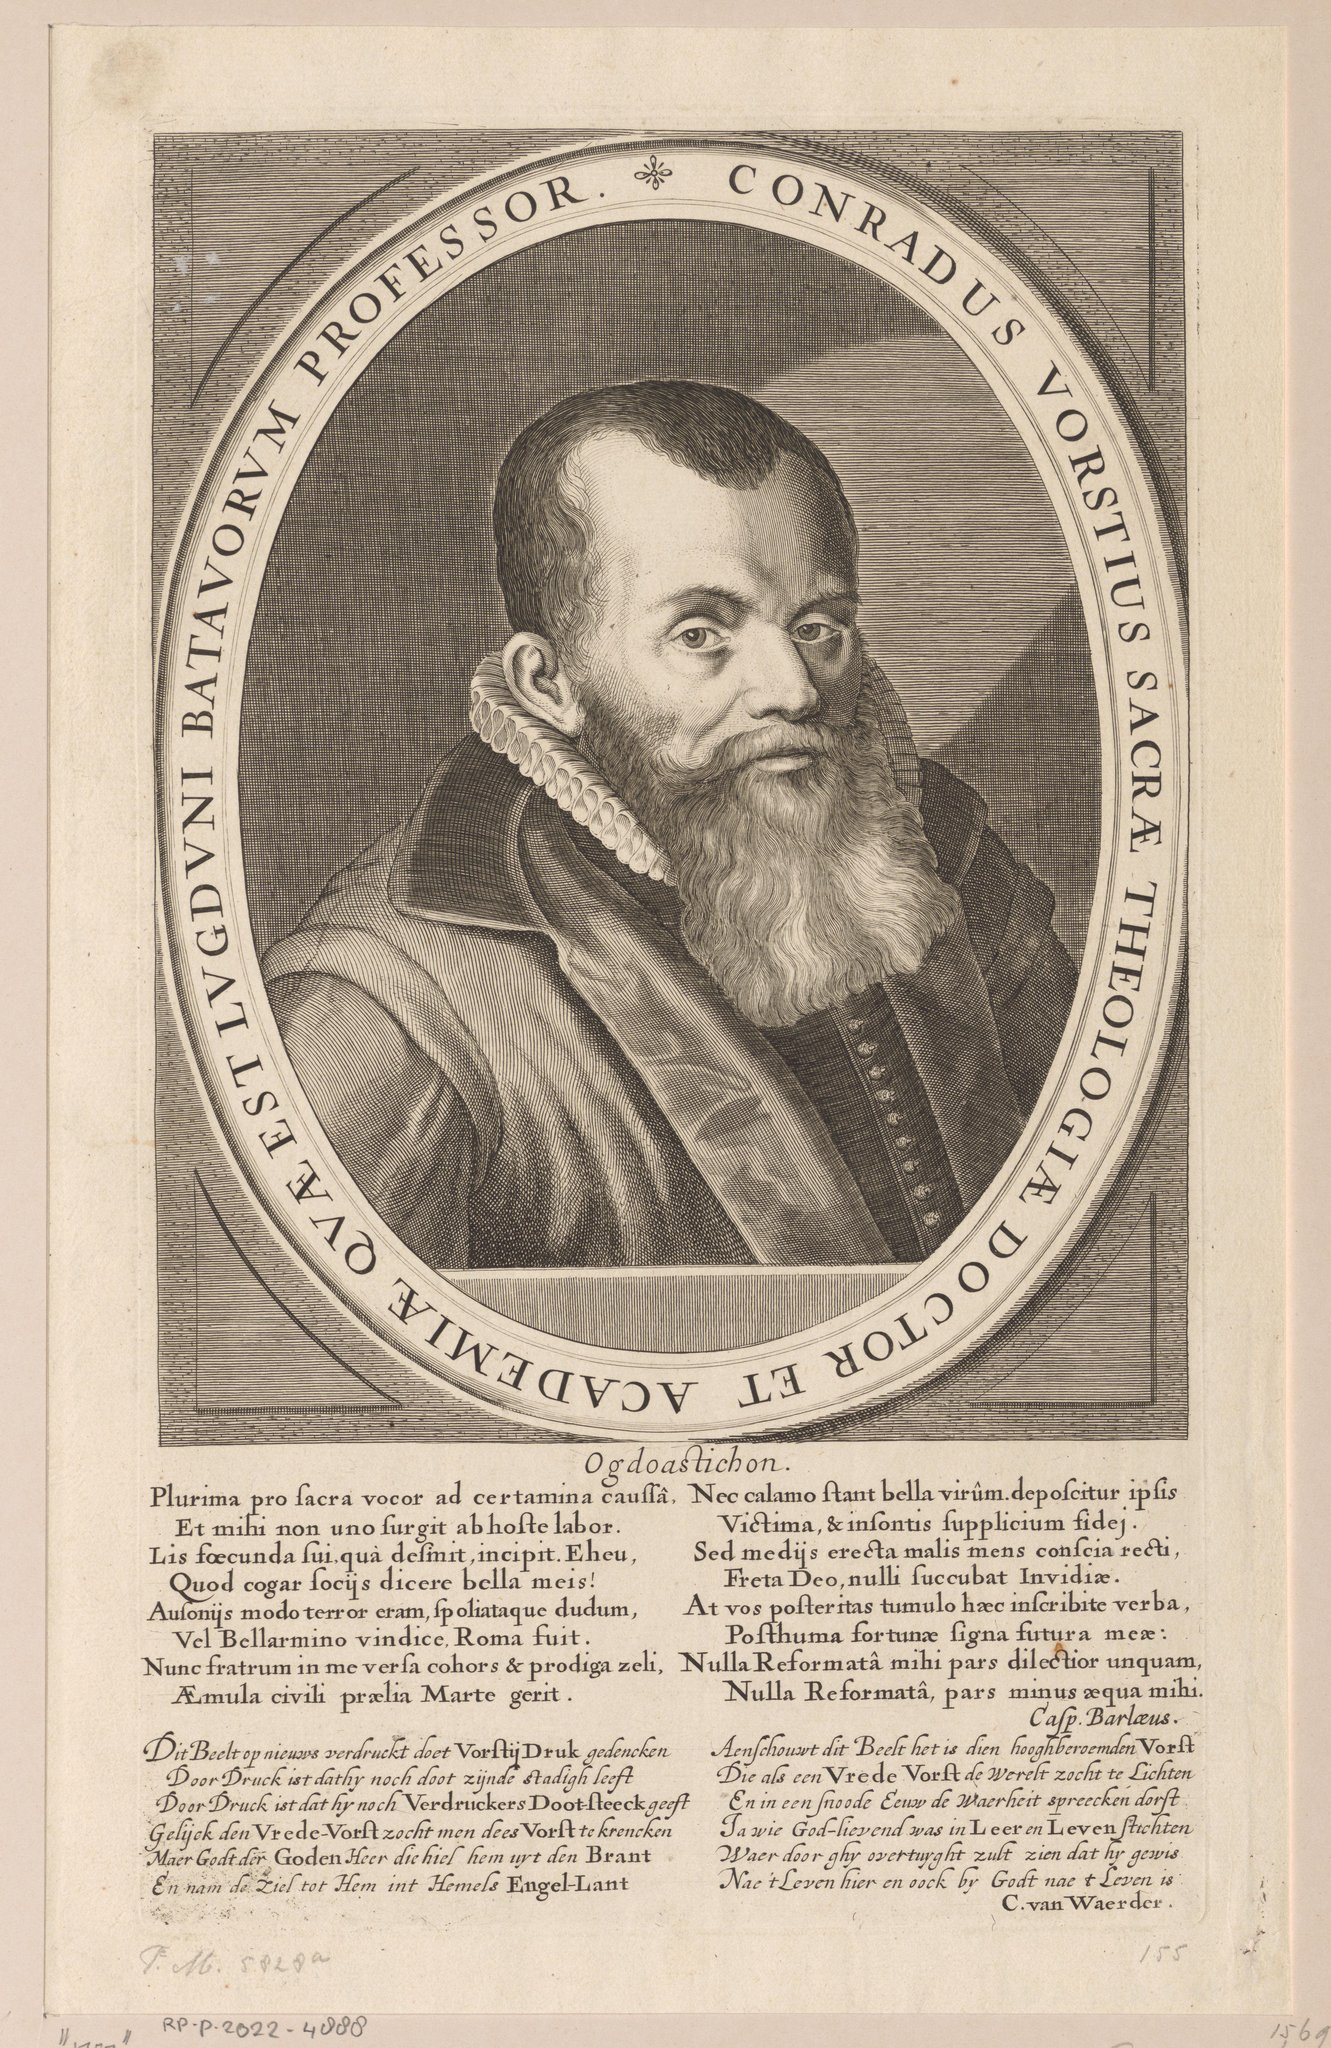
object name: print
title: Portret van Conradus Vorstius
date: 1622-1648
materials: paper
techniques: engraving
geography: low countries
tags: theologian, historical persons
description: Met twaalfregelig onderschrift in het Nederlands en zestienregelig onderschrift in het Latijn.